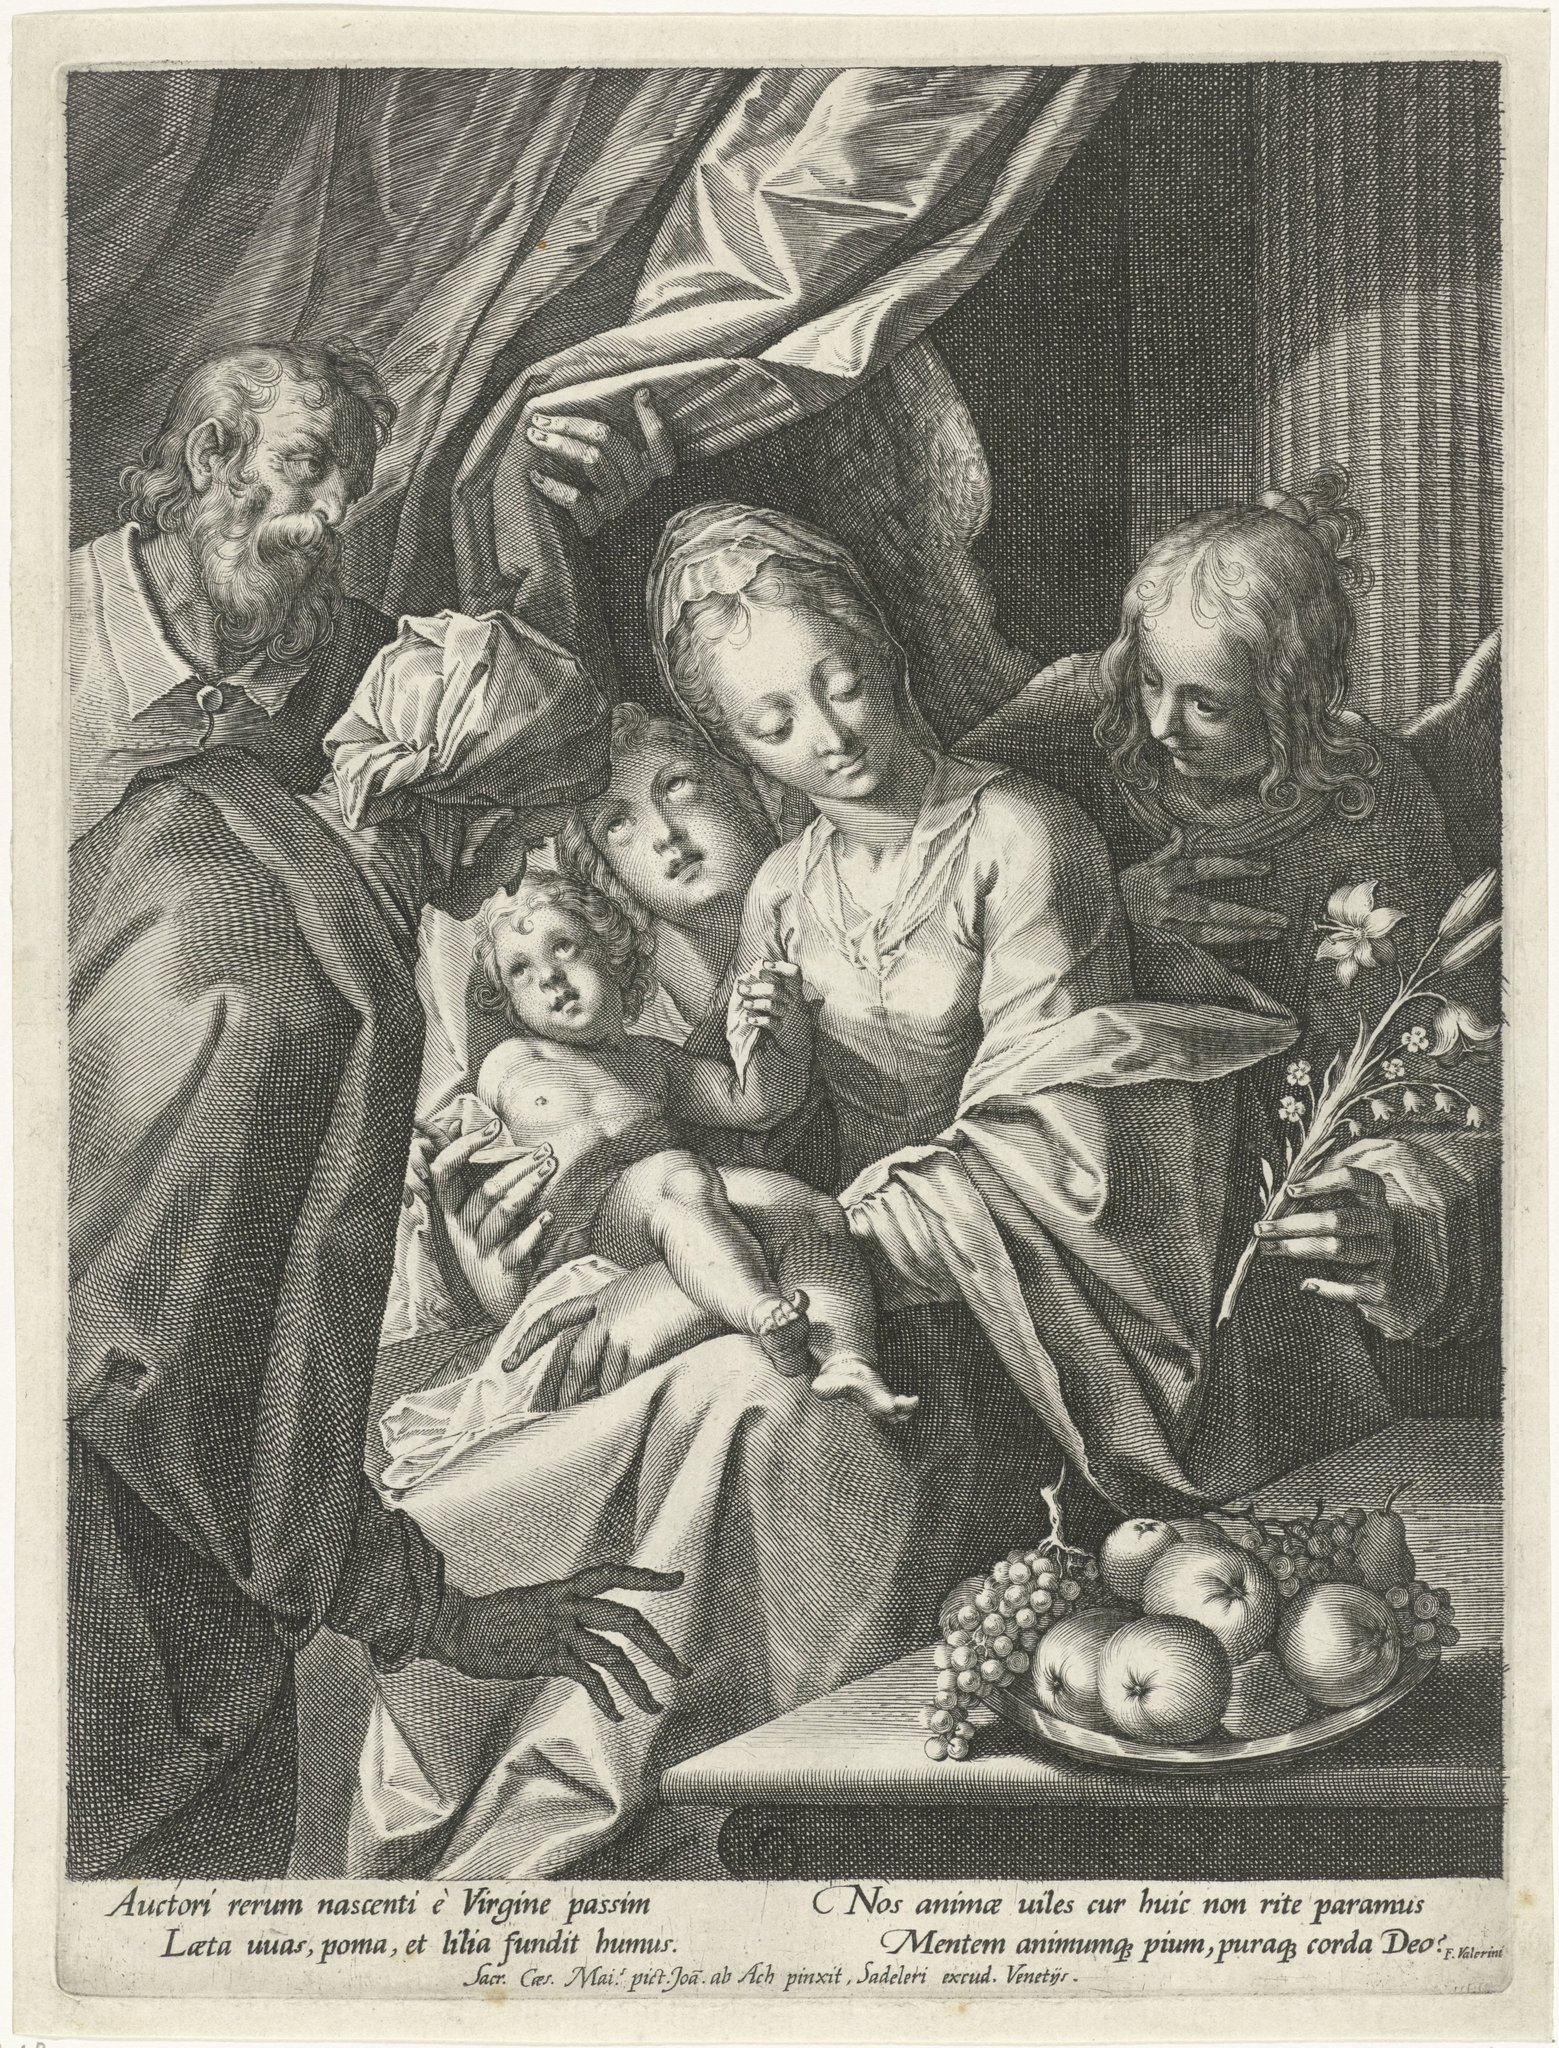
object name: print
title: Heilige familie met de heilige Anna en twee engelen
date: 1593-1679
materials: paper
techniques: engraving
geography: venice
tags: holy family with others, e.g.: anna (+ angel(s)), 'anna selbdritt' with joseph present (+ angel(s)), flowers: lily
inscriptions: collector's mark: Lugt 240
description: De heilige familie met de heilige Anna en twee engelen. Een van de engelen houdt een lelie vast. Op de voorgrond rechts een schaal met fruit op een tafel.